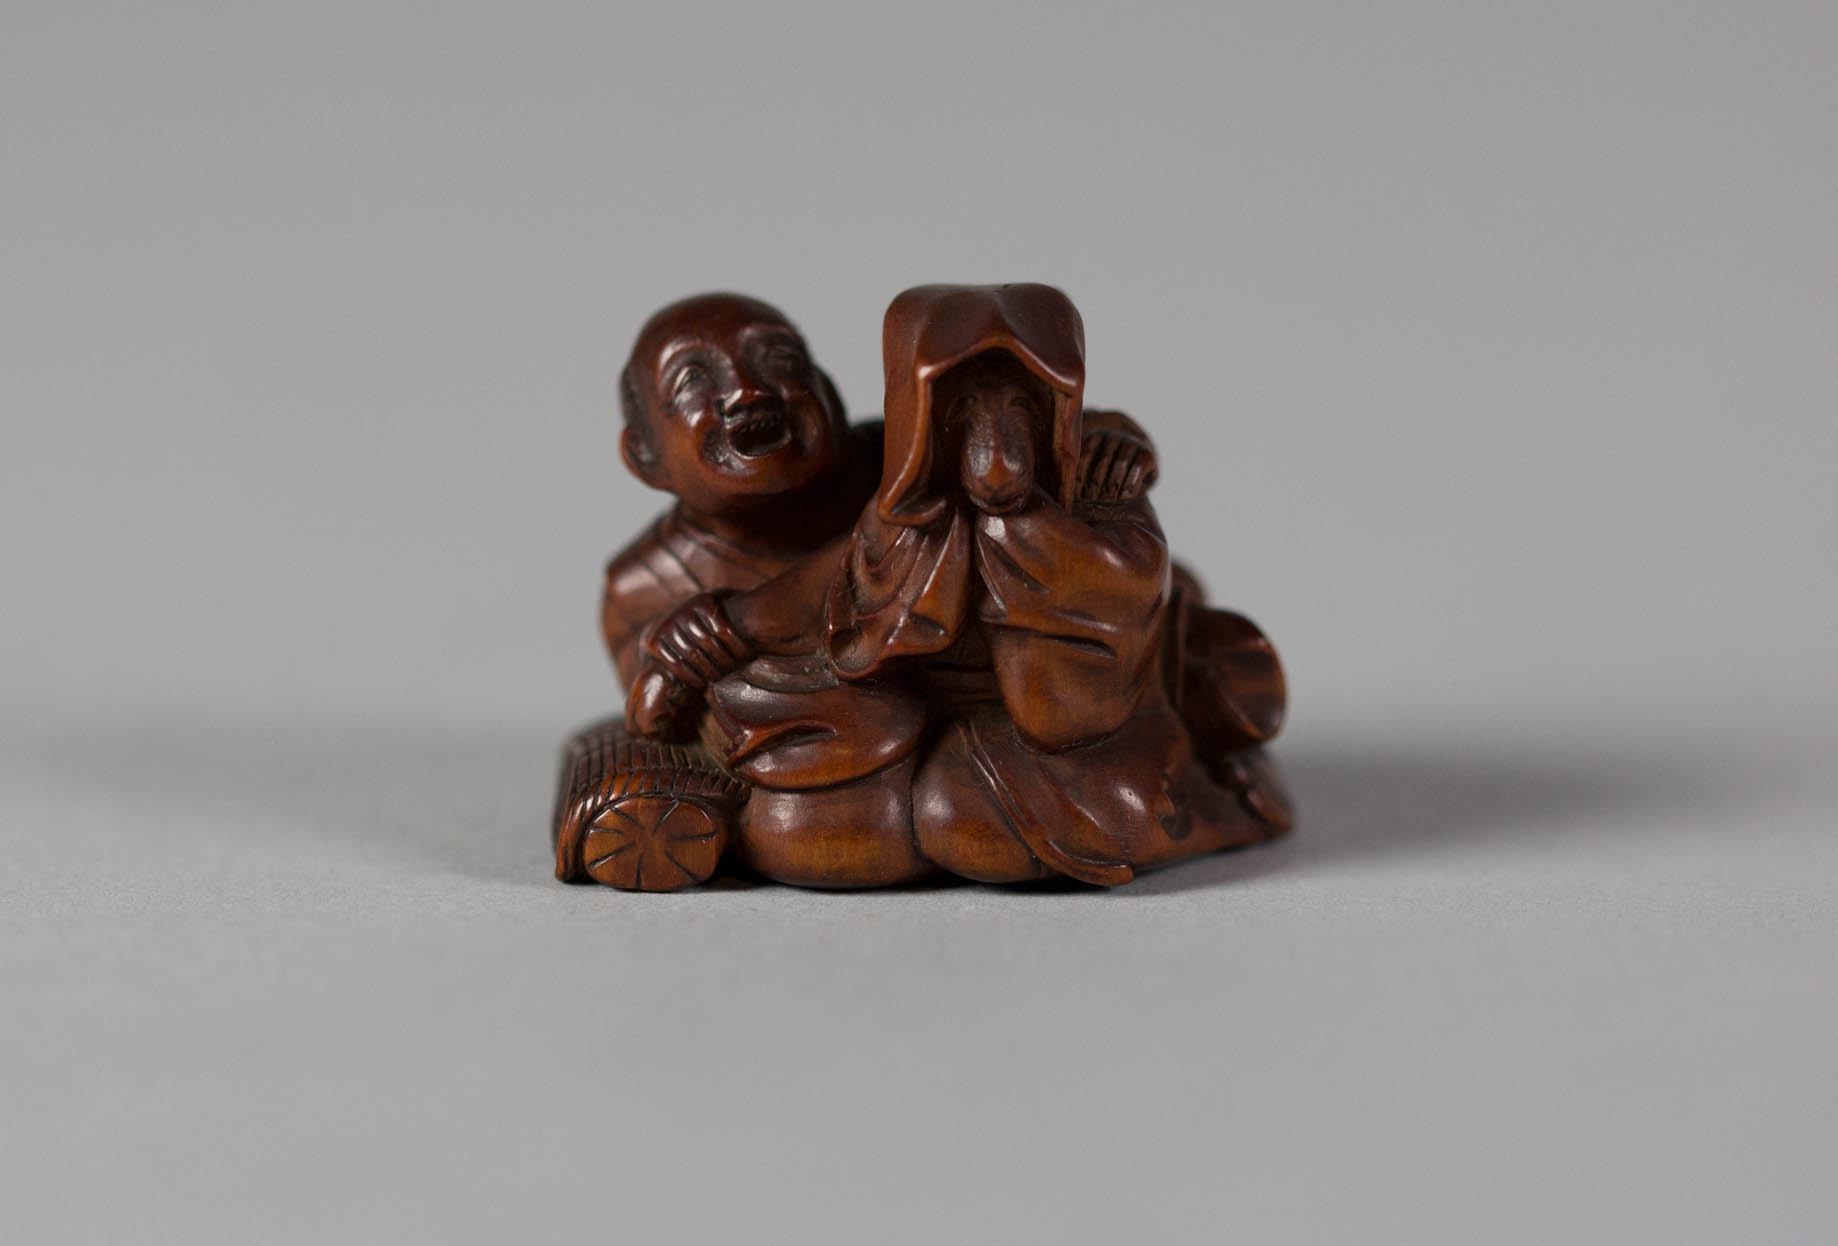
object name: netsuke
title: Netsuke of Tokutaro and Fox Disguised as a Woman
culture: japanese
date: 1801-1900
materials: wood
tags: men,foxes